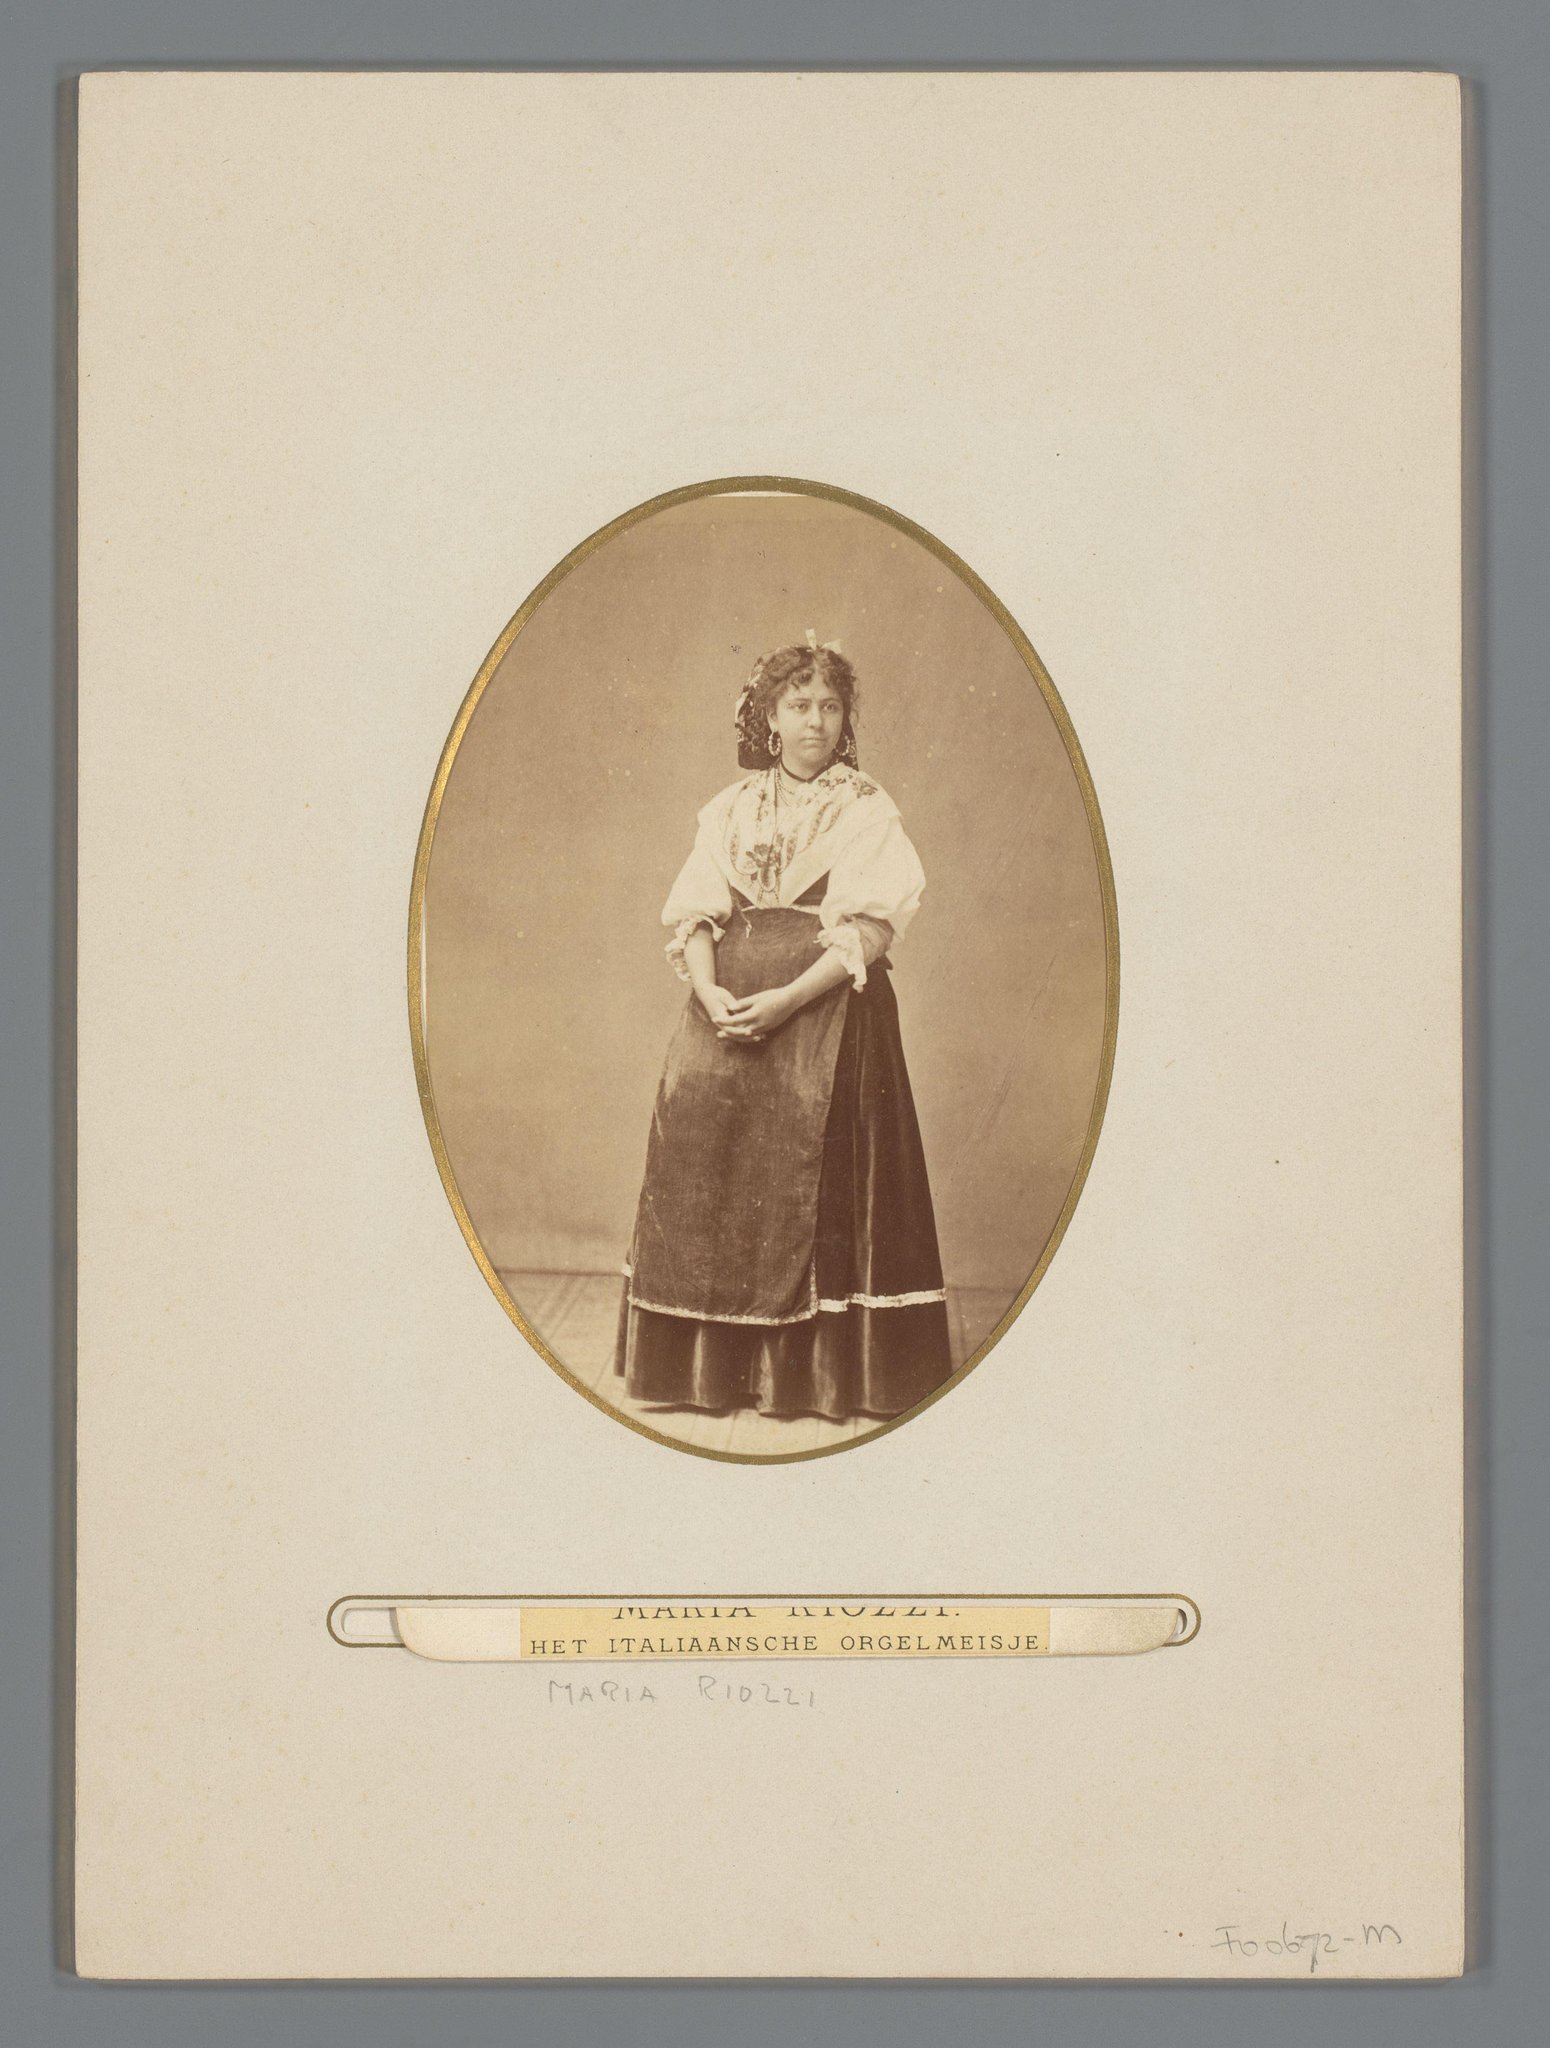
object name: photograph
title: Maria Riozzi, het italiaansche orgelmeisje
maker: charles binger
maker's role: print maker, printer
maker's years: 1830-1916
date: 1870-1890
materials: cardboard, photographic support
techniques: albumen print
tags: musician, adult woman, historical persons, portrait of a musician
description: Deze foto maakt deel uit van een omslag met 22 foto's.